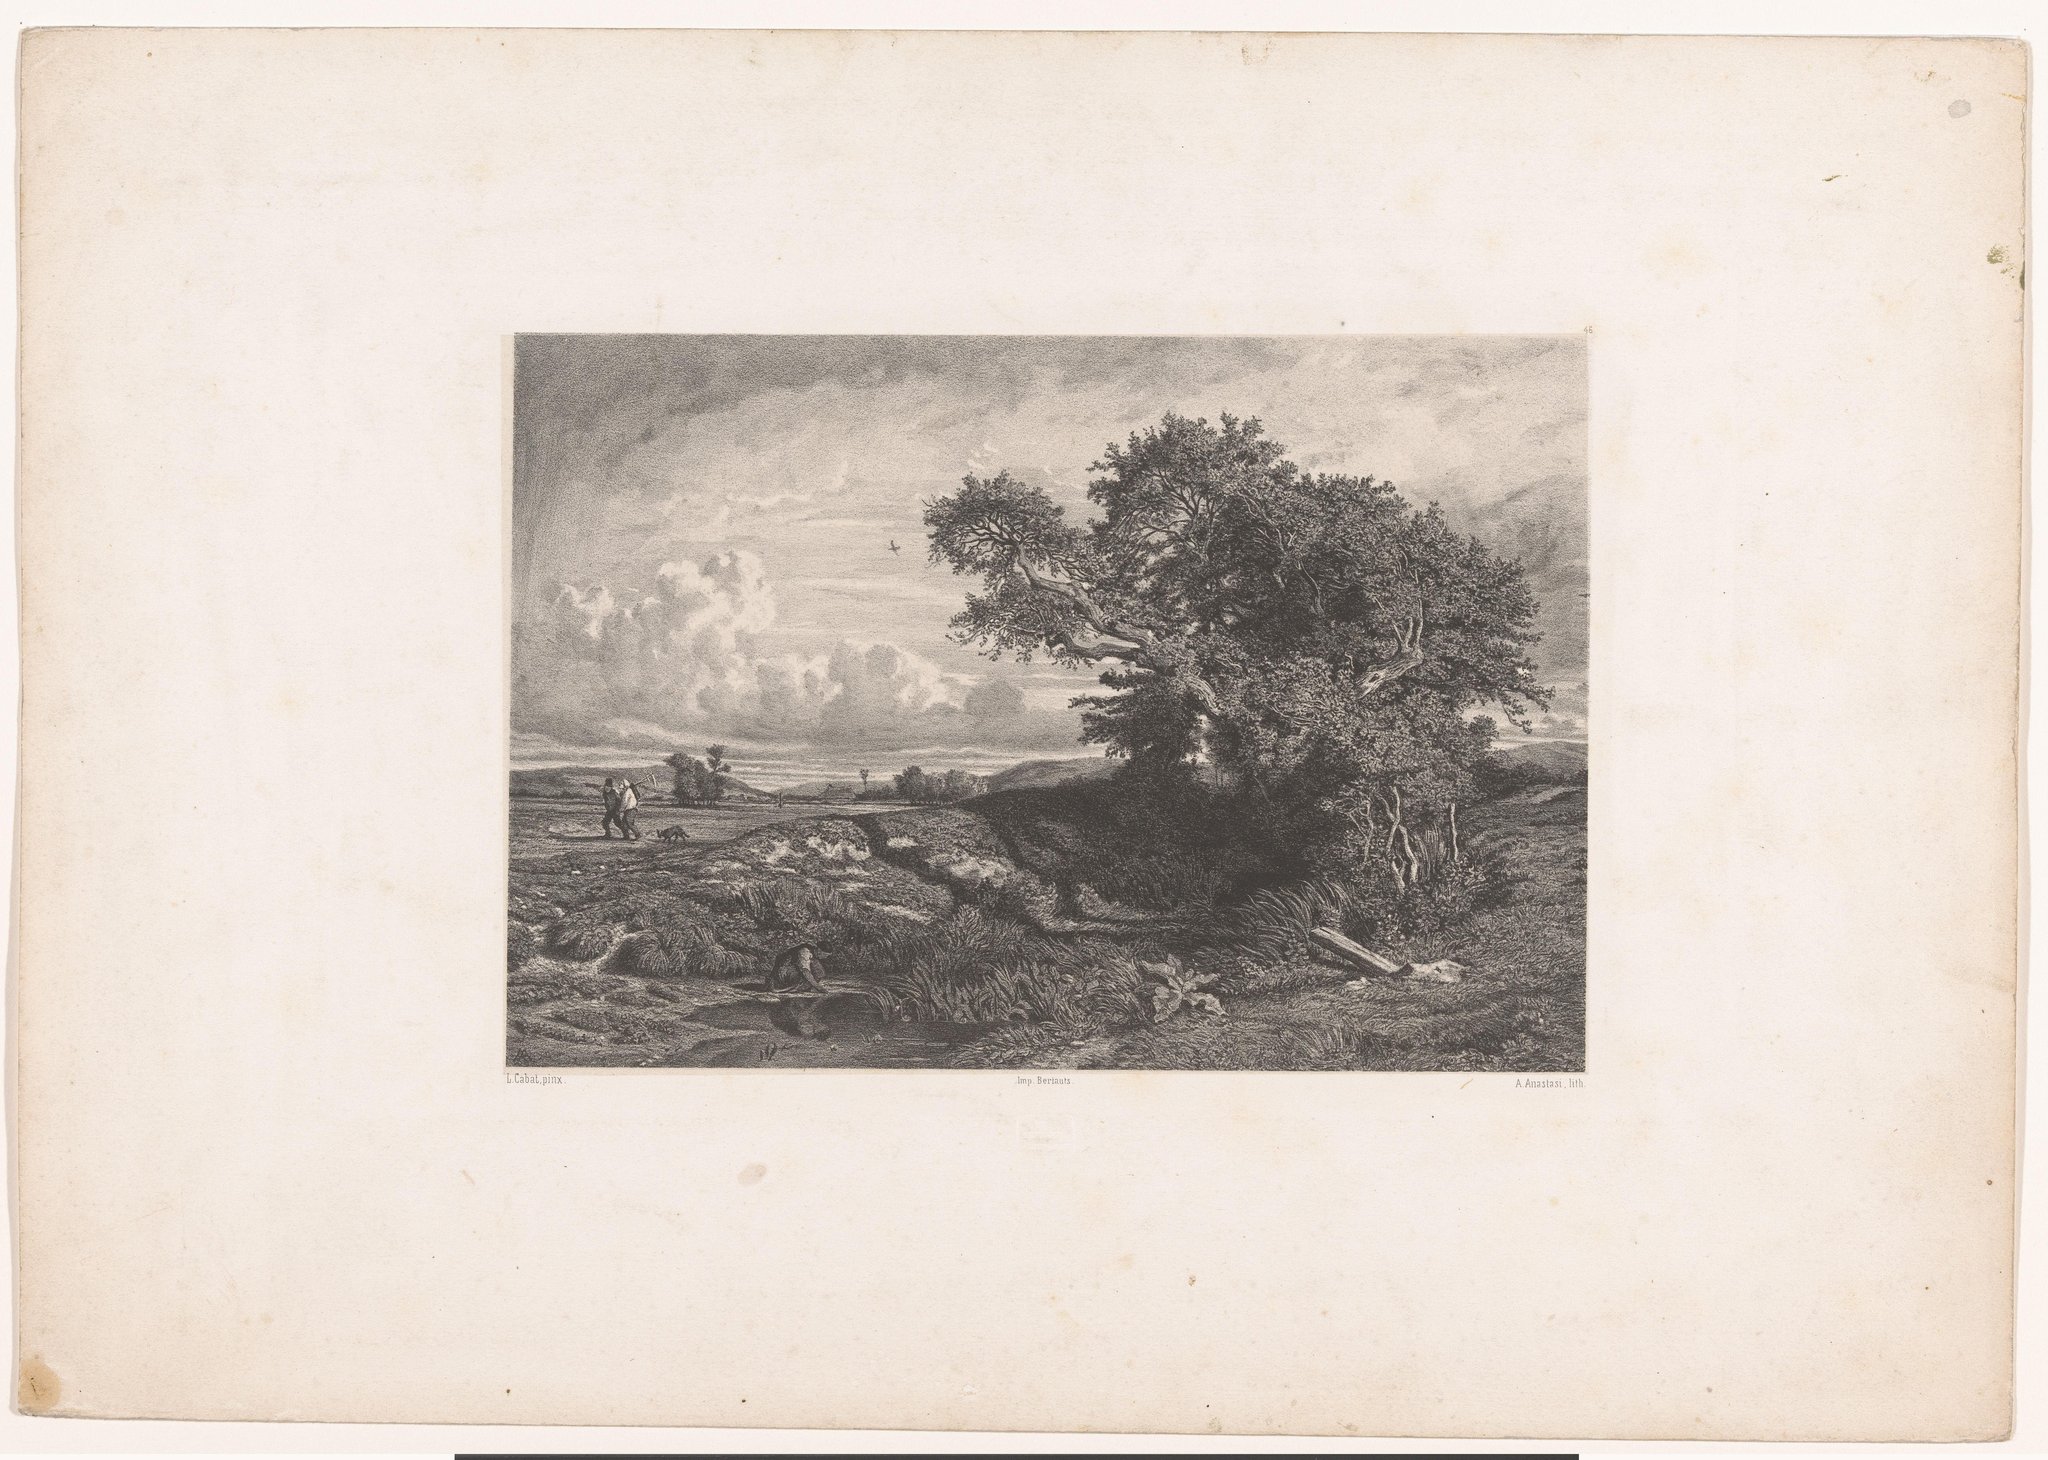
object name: print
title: Heuvellandschap met boom en vijver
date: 1847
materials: paper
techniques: tone lithography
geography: paris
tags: low hill country, trees, landscapes (+ landscape with figures, staffage)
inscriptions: collector's mark: Lugt 2228, check stamp: Lugt 36b